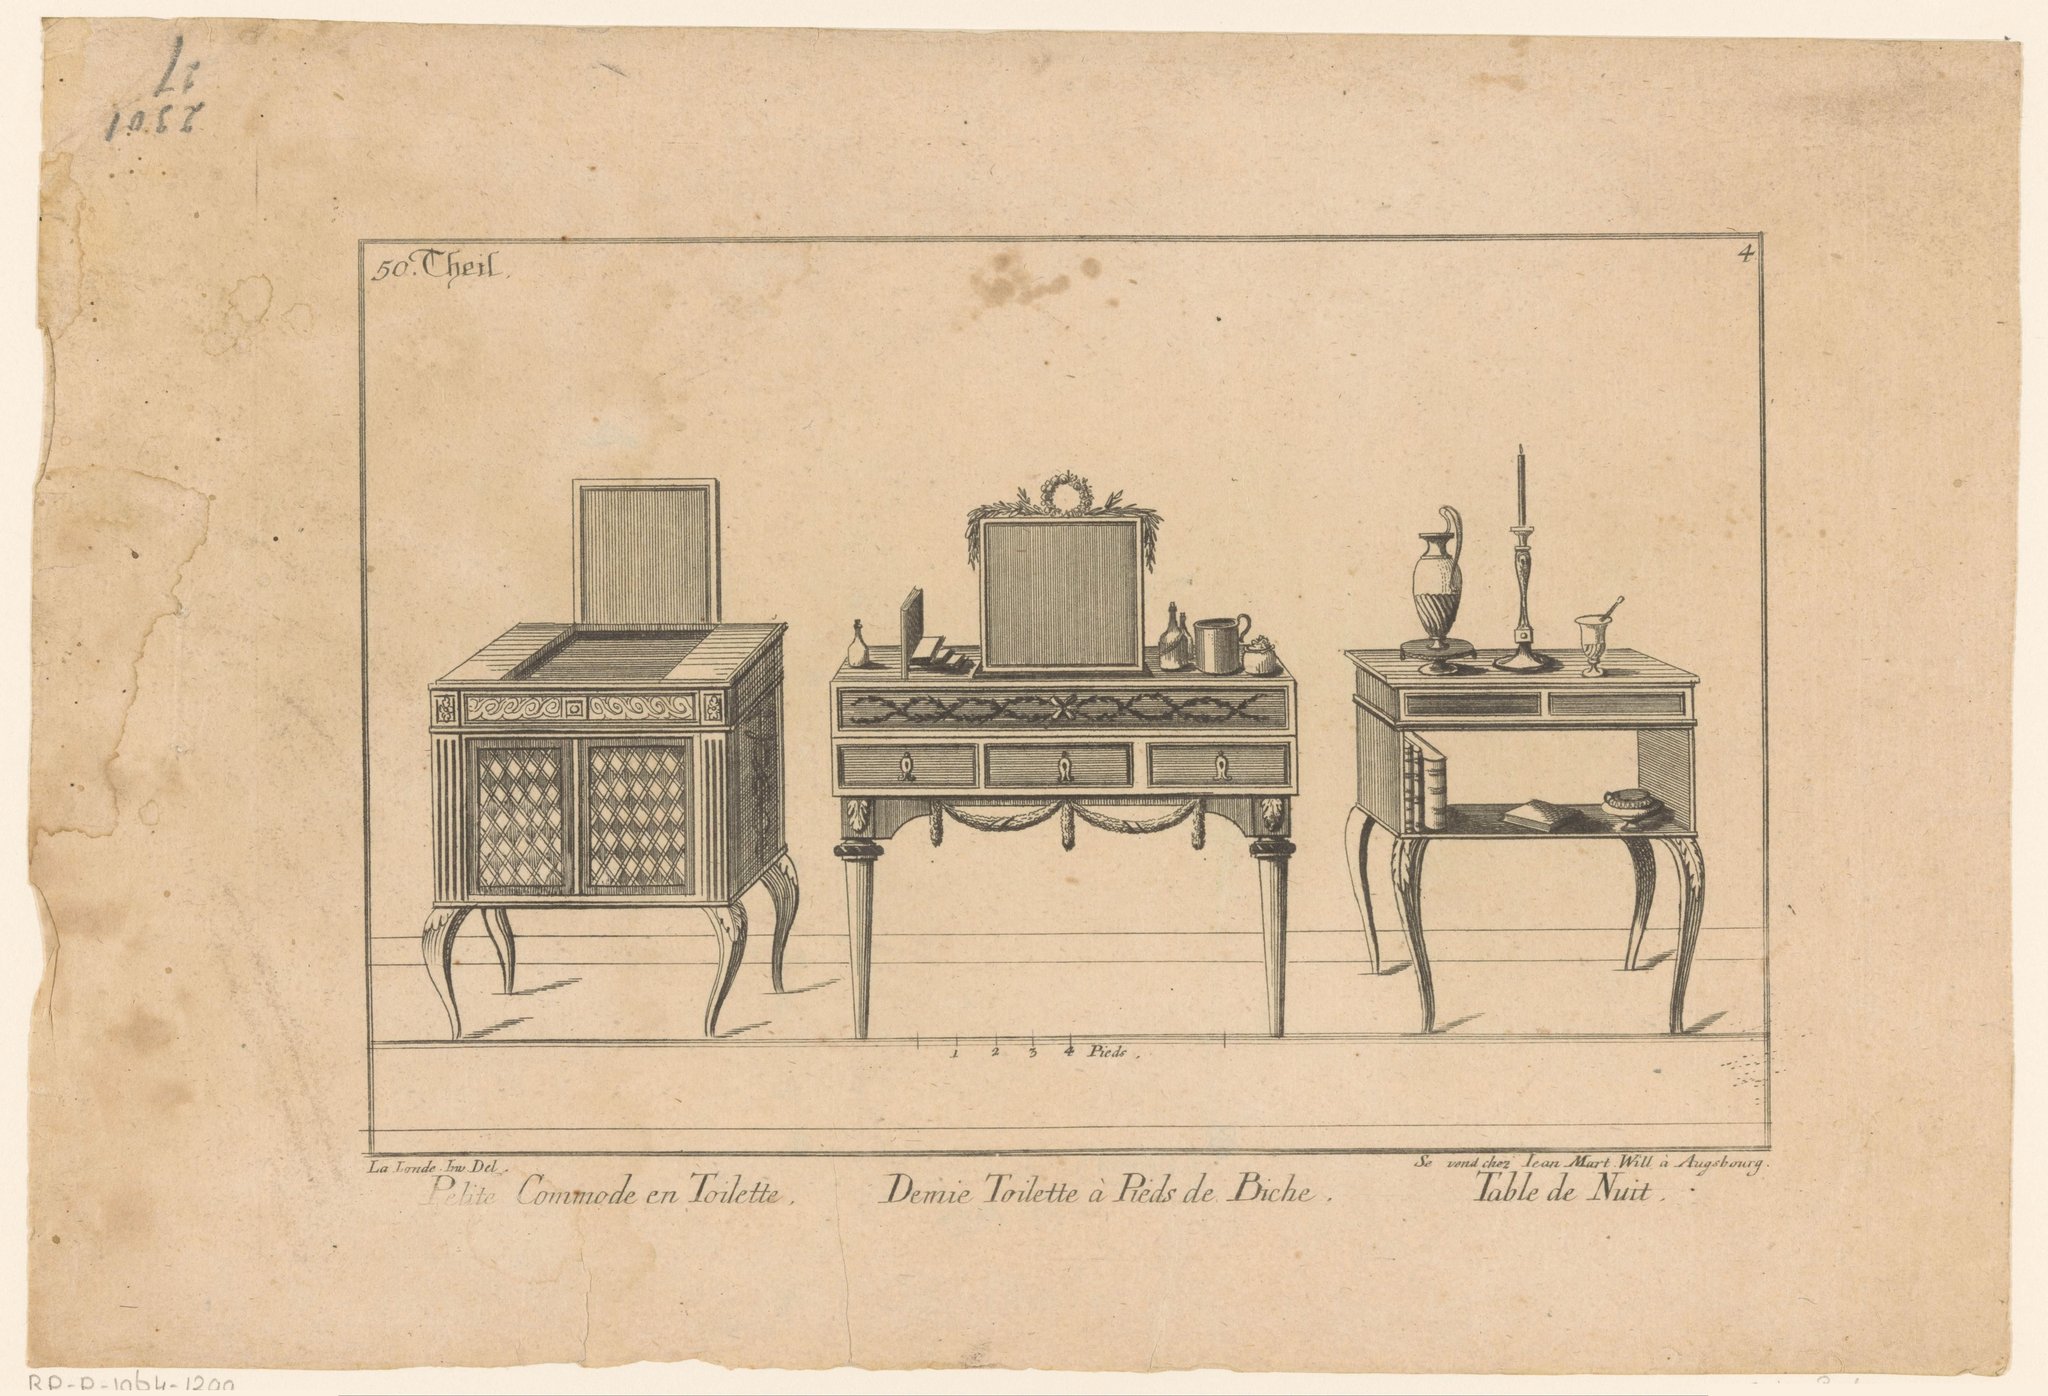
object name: print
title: Commode, toilettafel en nachtkast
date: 1784-1806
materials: paper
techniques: engraving, etching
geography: augsburg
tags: ornamental cupboard, table, courtyard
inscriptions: collector's mark: Lugt 2760, collector's mark: Lugt 2228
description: Links een commode met opklapbaar deel, gedecoreerd met ruitmotief en een Mercuriusstaf. In het midden een toilettafel met drie lades, een opklapbaar deel, een kan, flessen en boeken. Rechts een nachtkast met twee lades en een plank, met een kan, kandelaar, boeken en een schaal.